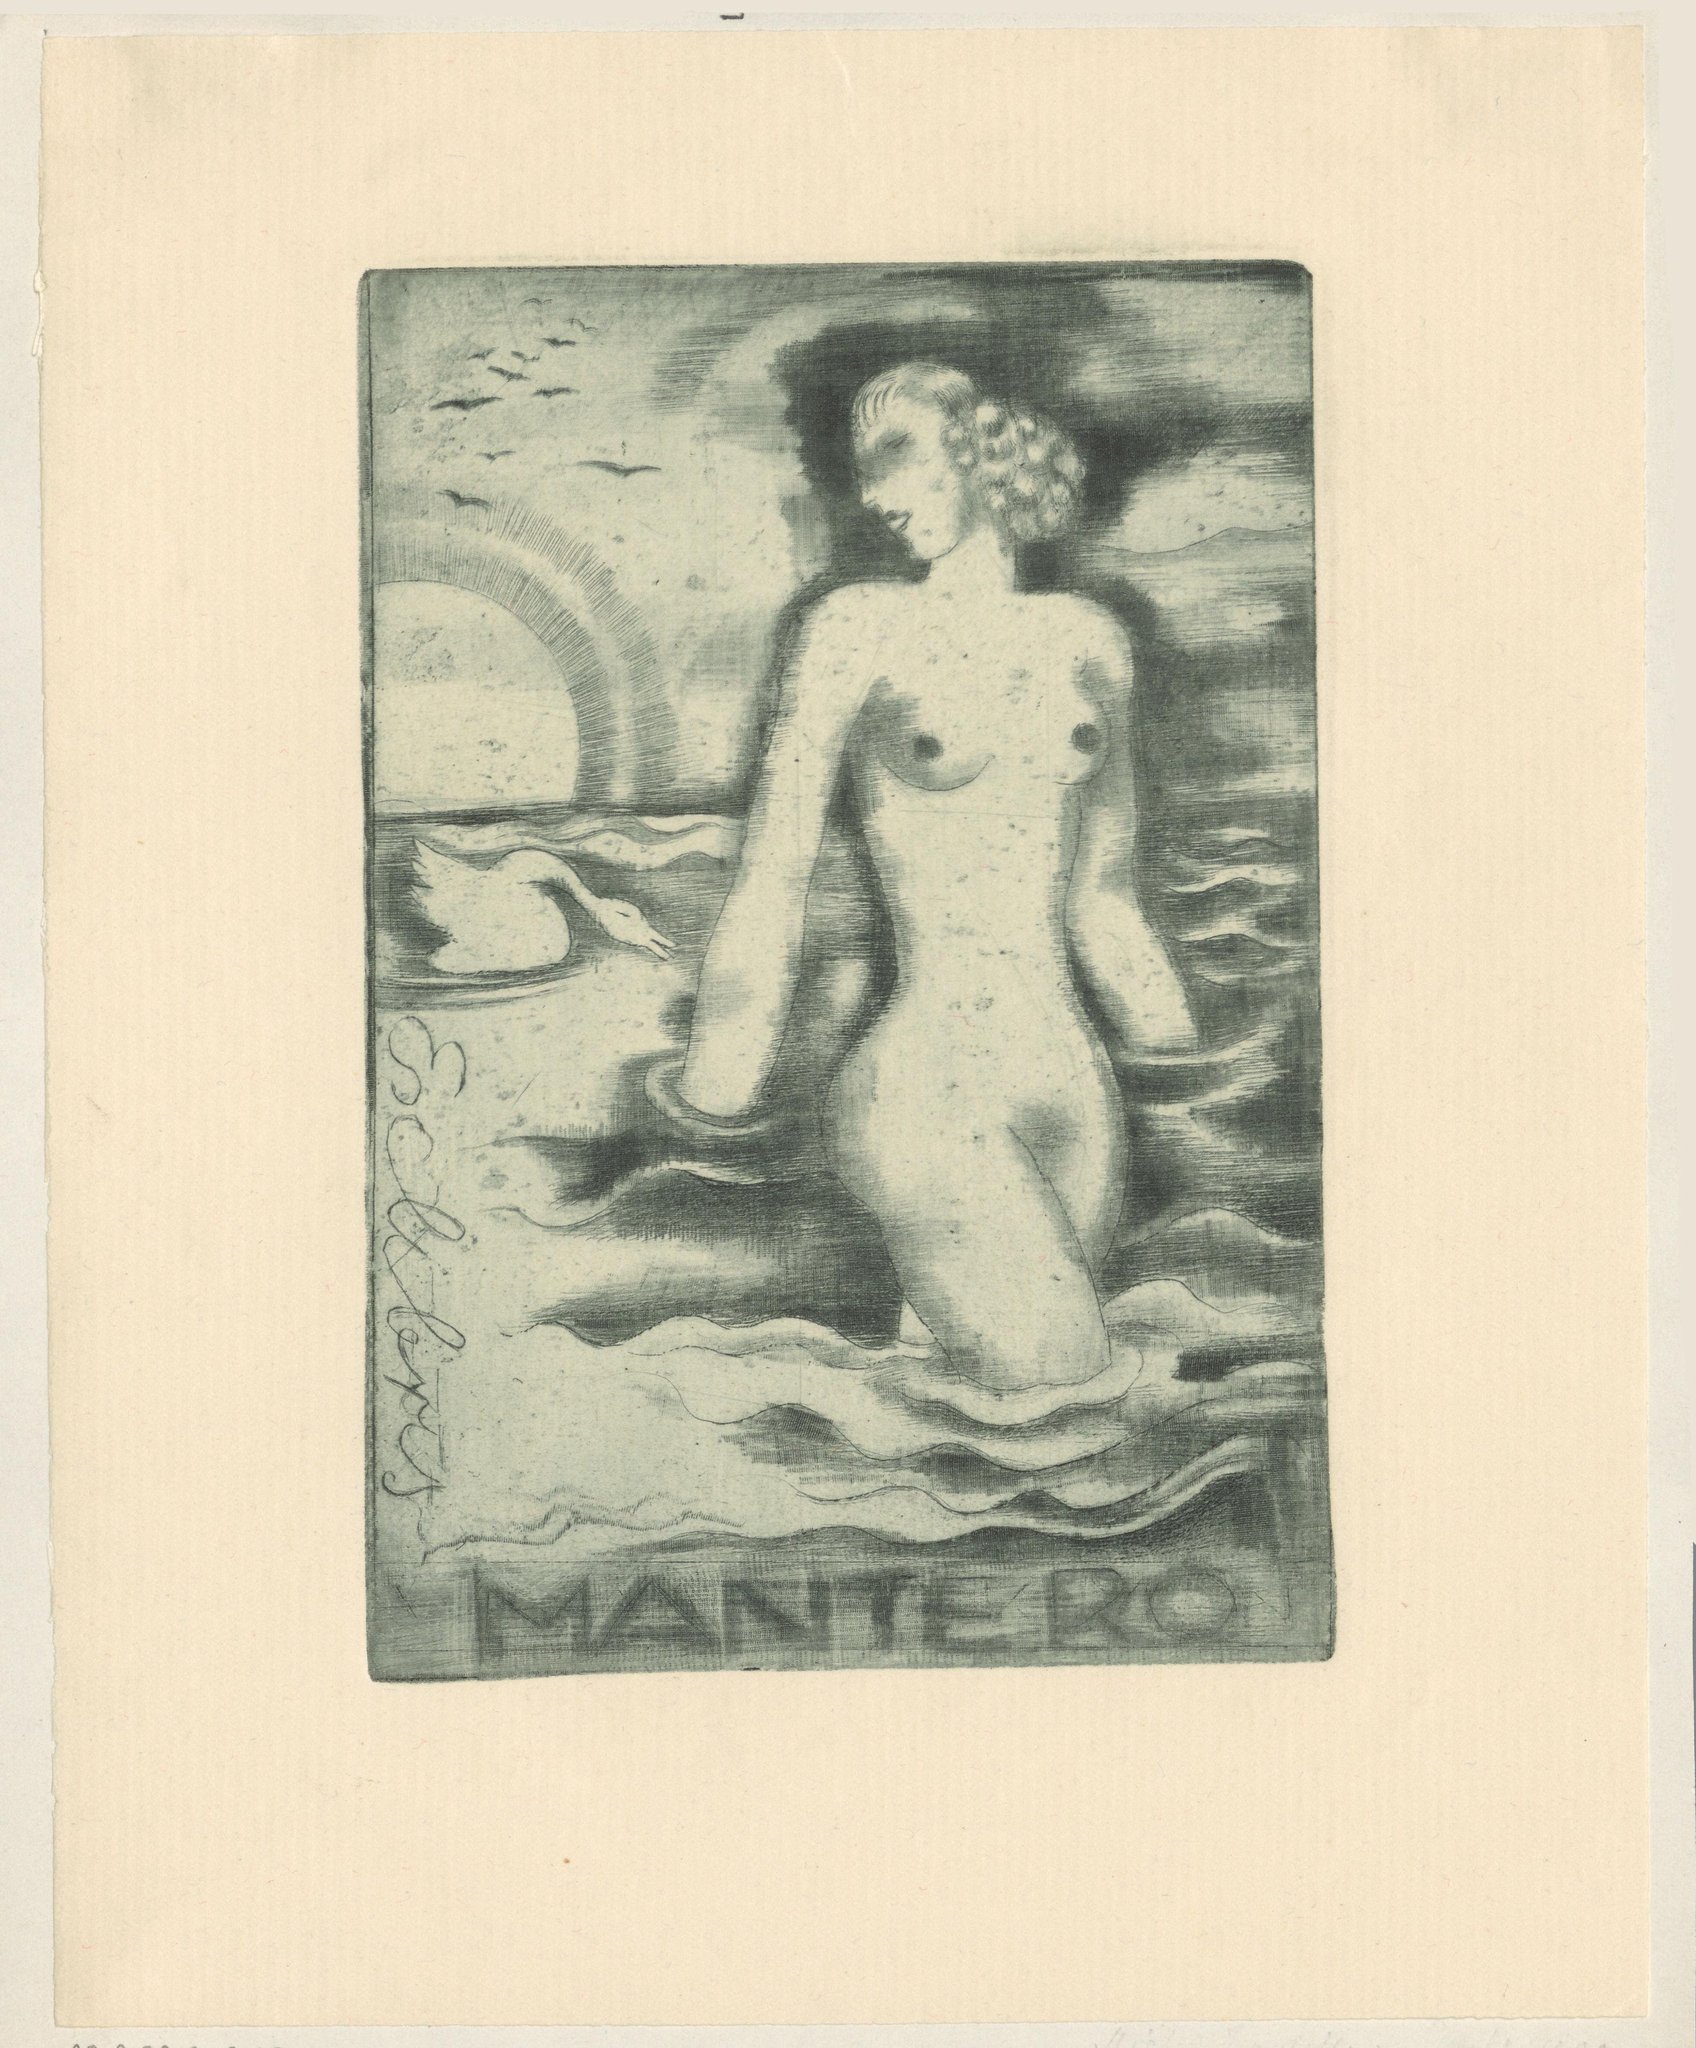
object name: bookplate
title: Ex libris van Mantero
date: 1930-1943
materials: paper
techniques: photograph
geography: milan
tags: engineer, gianni mantero, water-birds: swan, woman (showing herself) undressed, quasi-nude, sun as celestial body, sea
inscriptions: workshop stamp: ‘Michel Fingesten / Milano / Punta secca originale / Pointe seche originale / Orig. kalte Nädel-rad’